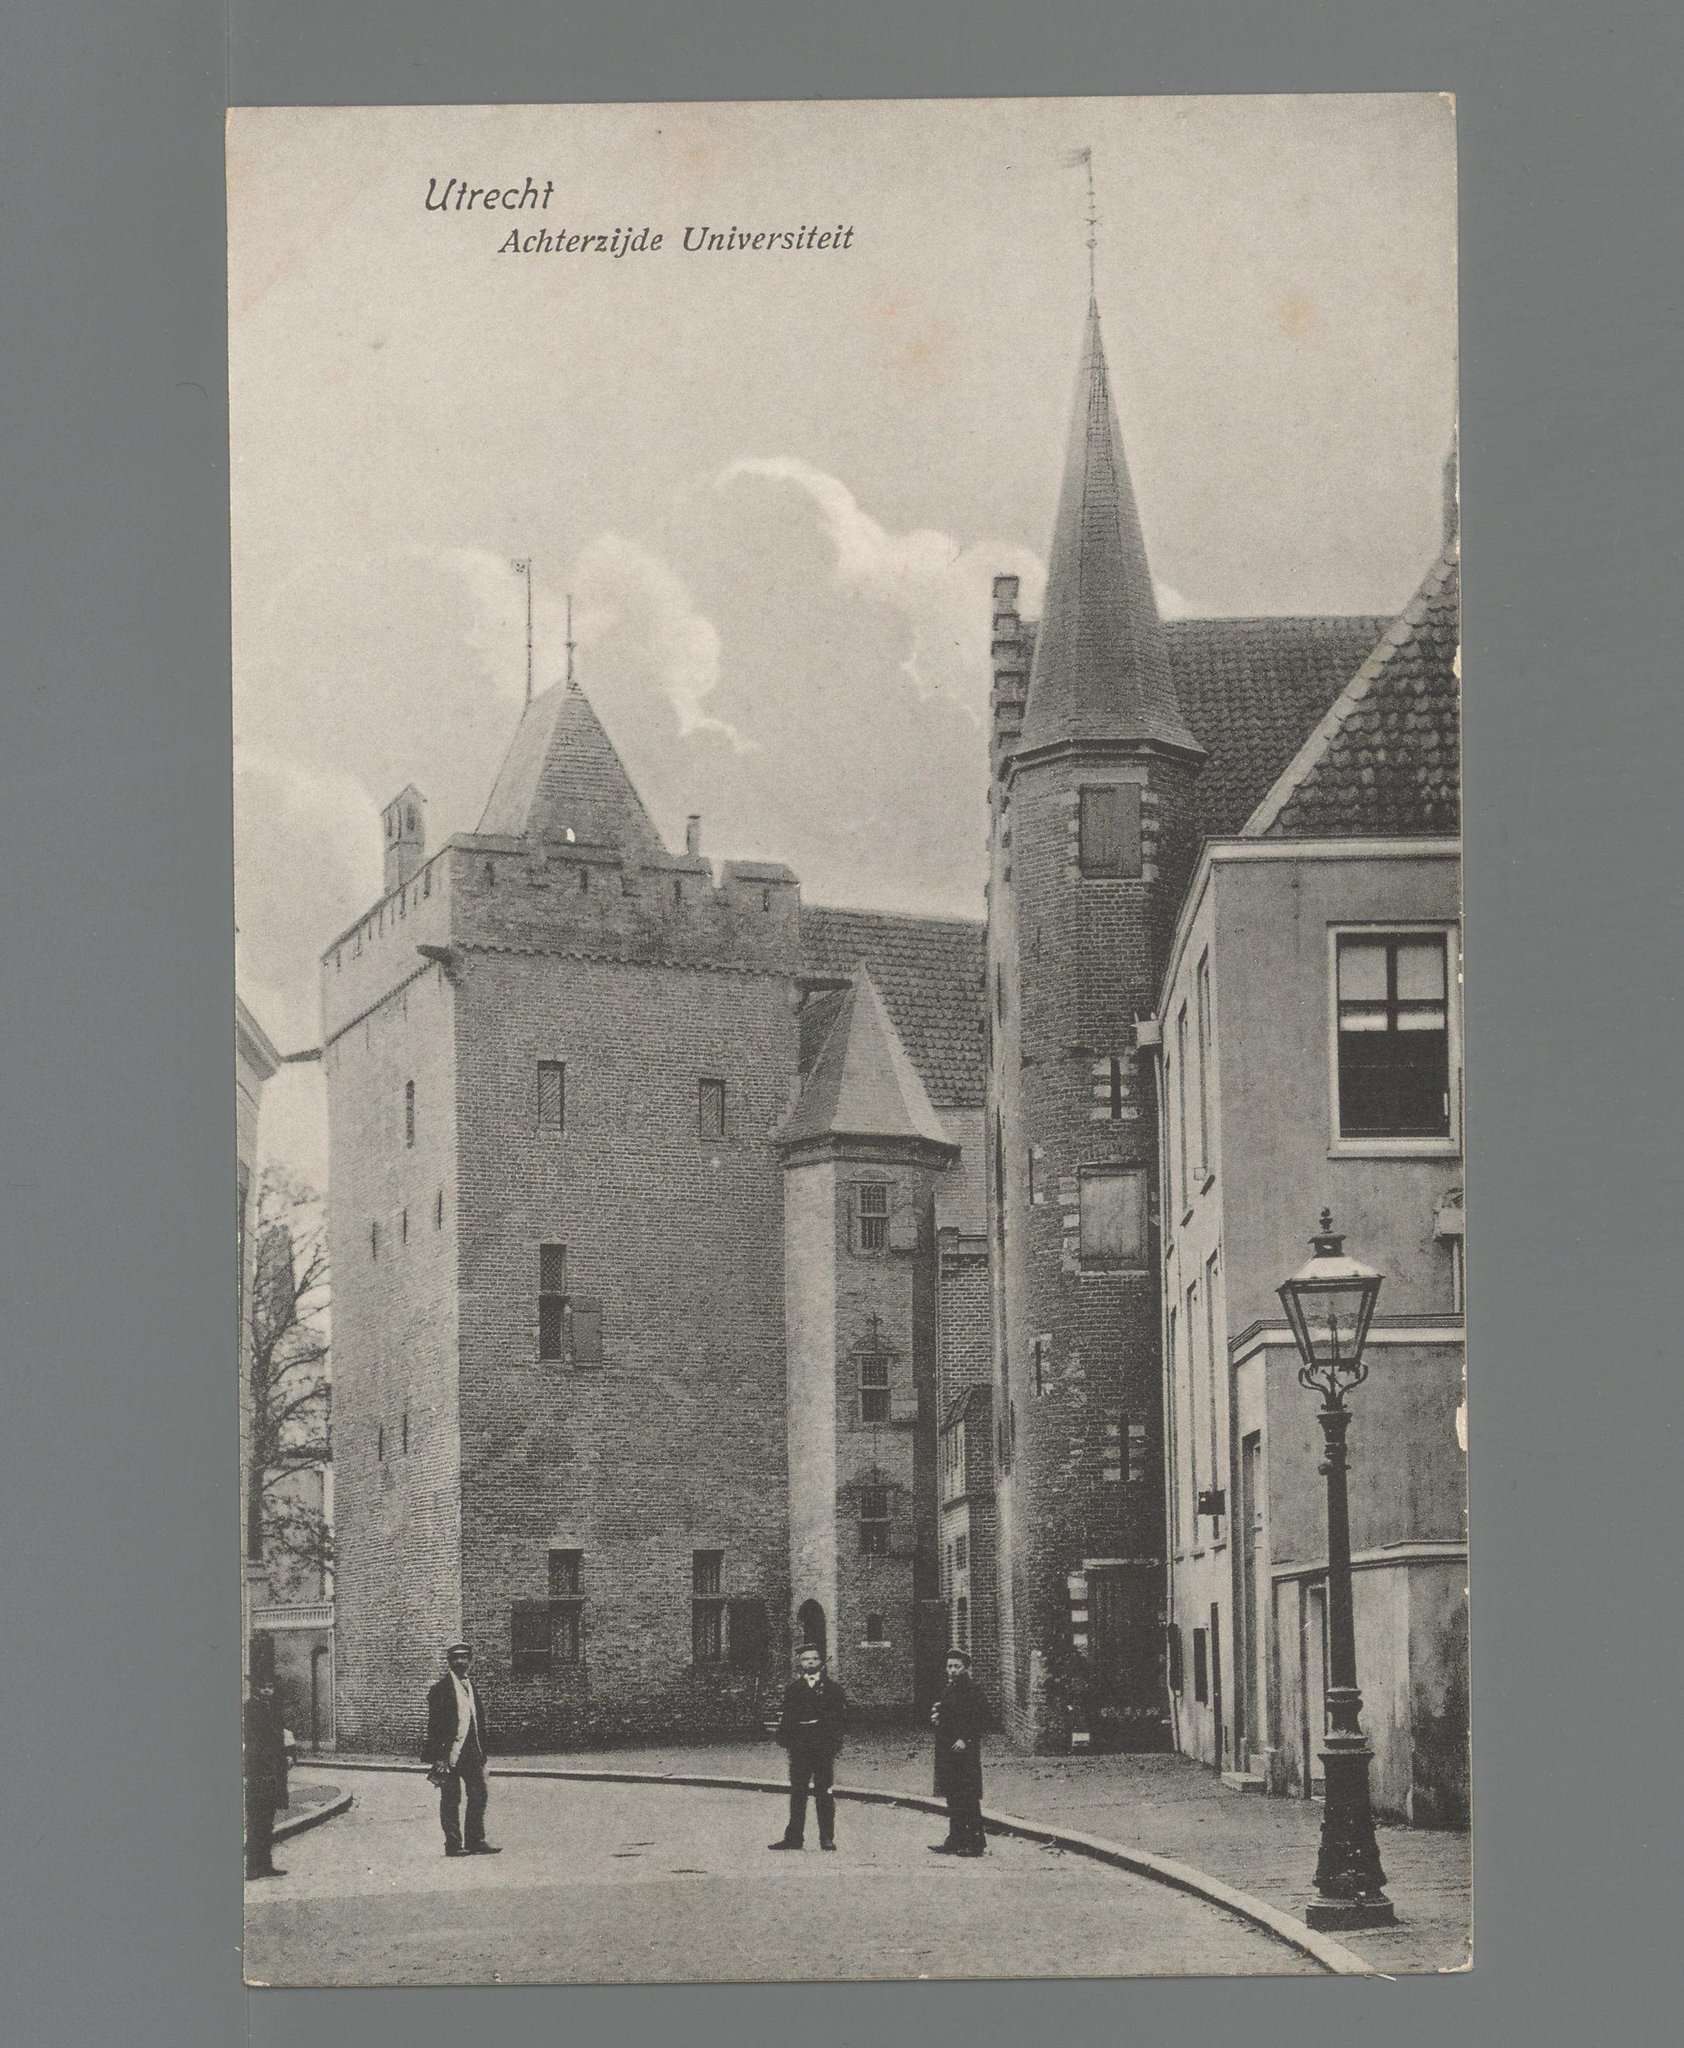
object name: ansichtkaart, prentbriefkaart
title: Utrecht. Achterzijde Universiteit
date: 1908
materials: cardboard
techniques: photograph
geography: utrecht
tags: university building, college, utrecht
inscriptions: date